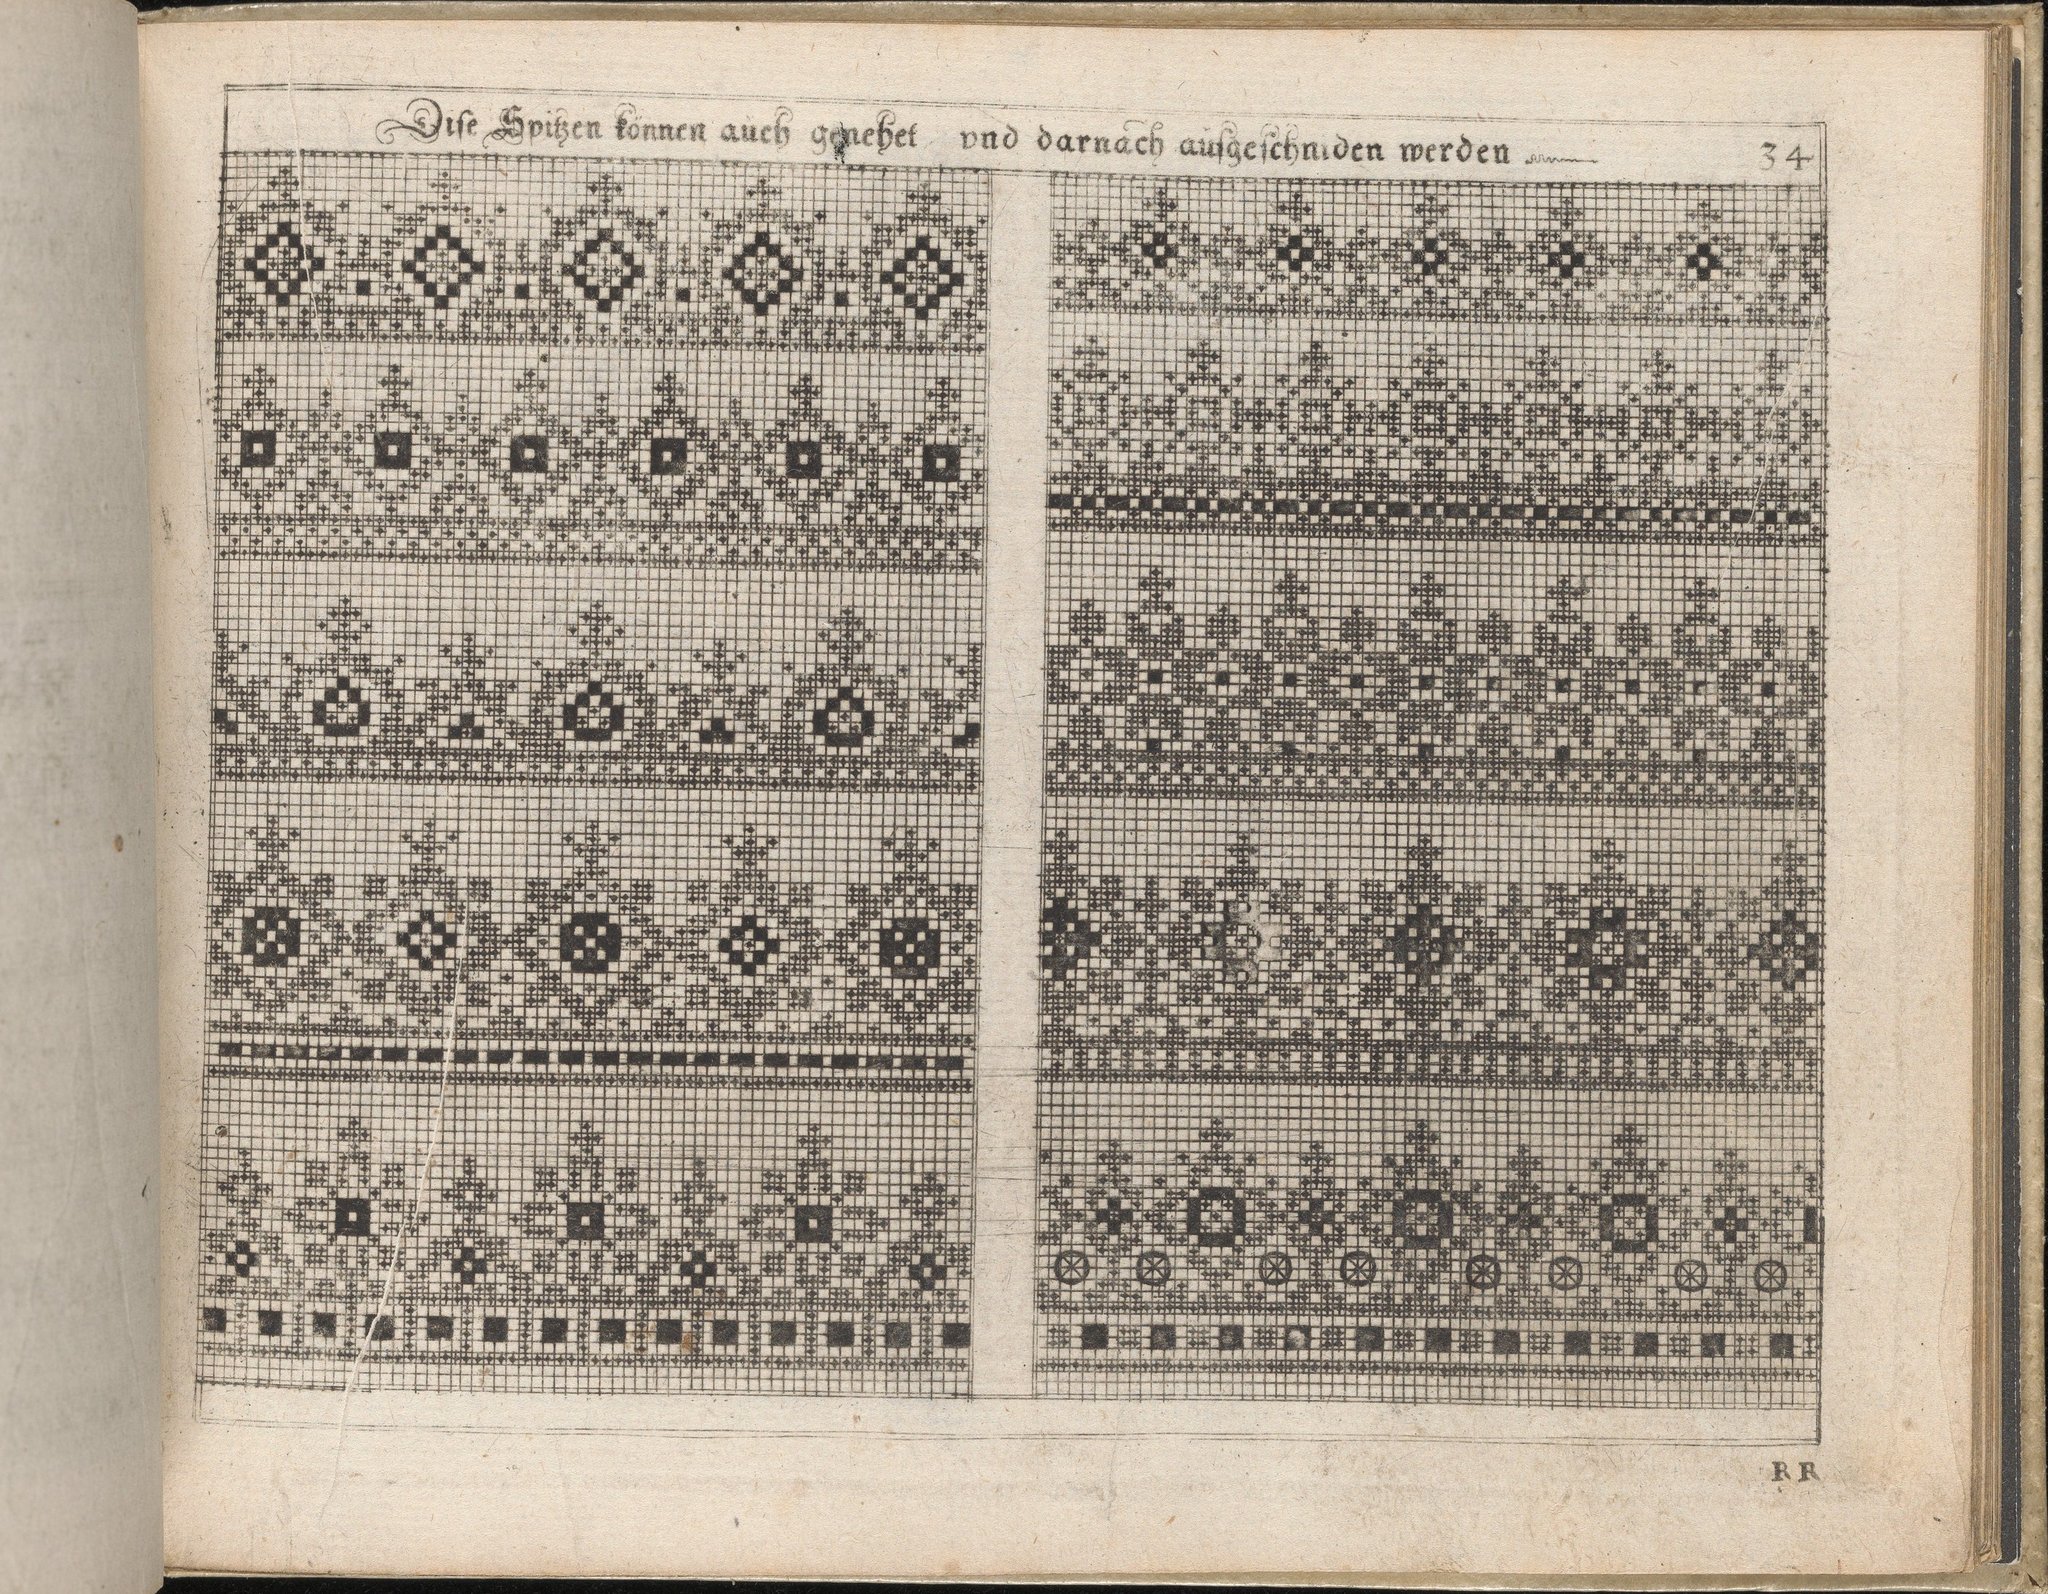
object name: book print ornament architecture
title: Newes Modelbuch in Kupffer (Page 42r)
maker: johann sibmacher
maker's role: artist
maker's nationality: german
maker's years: 1590-1611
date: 1604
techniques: etching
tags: ornament